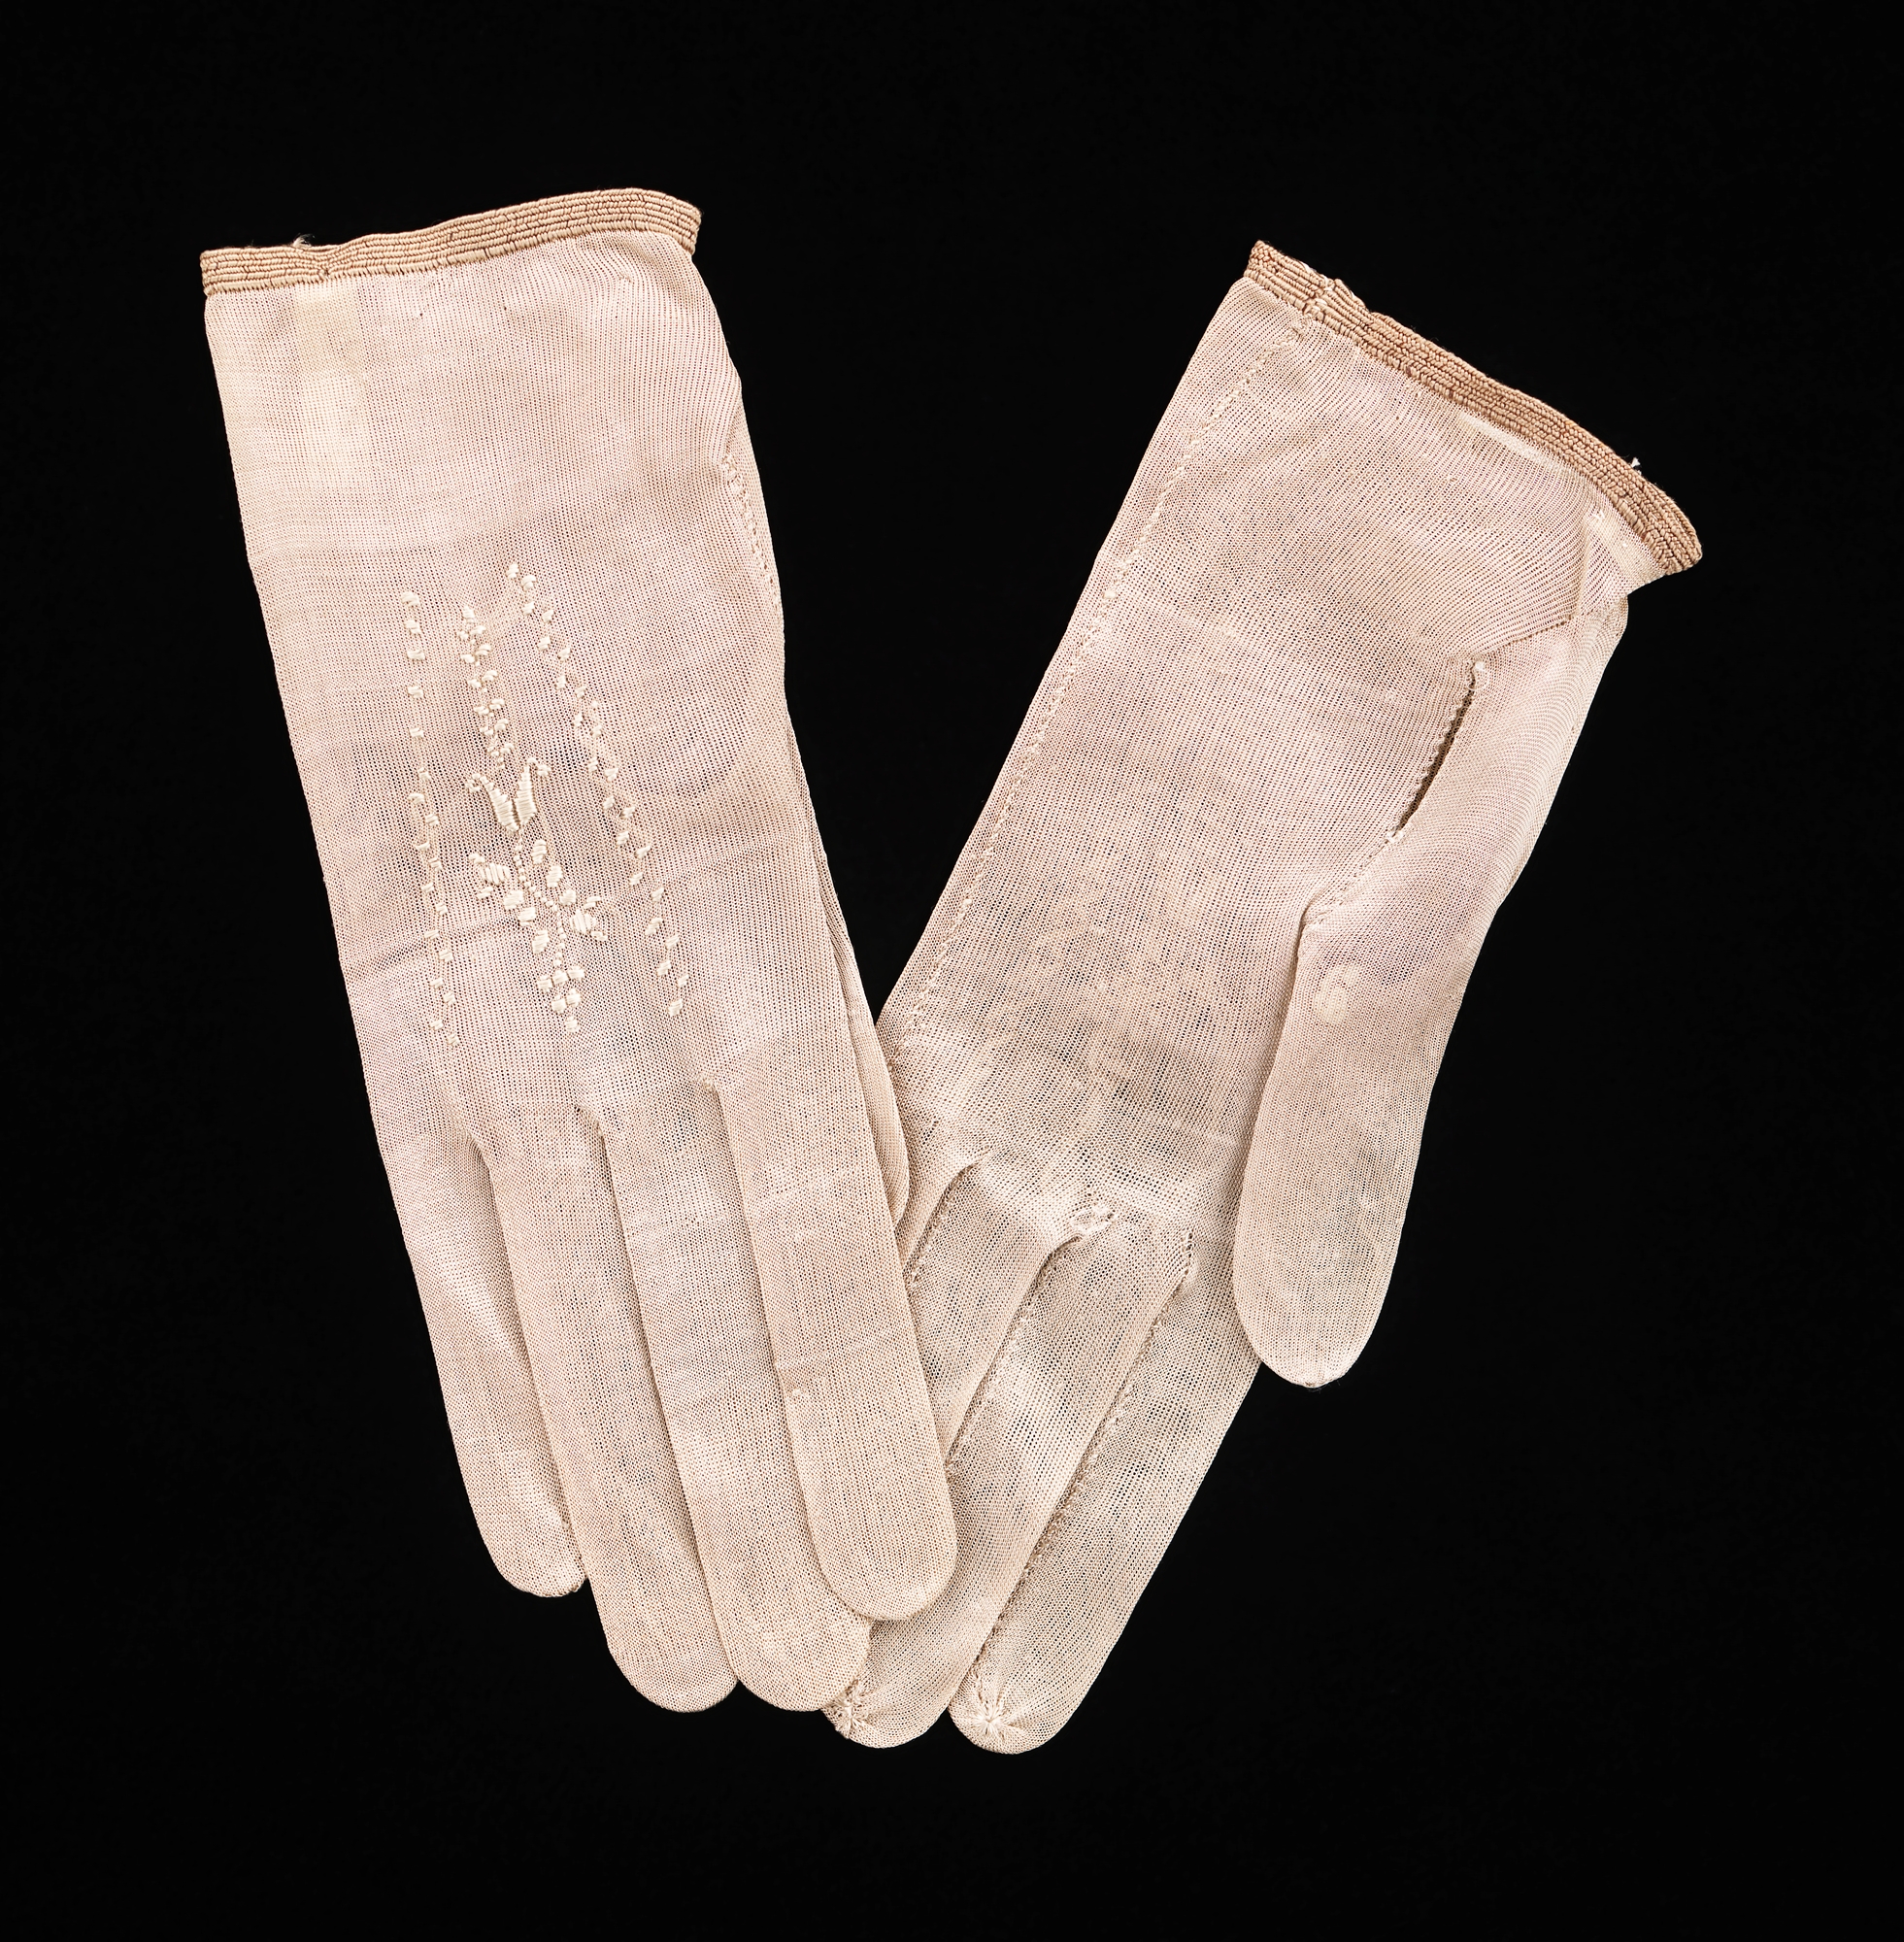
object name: glove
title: Gloves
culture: american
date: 1840-1860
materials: silk